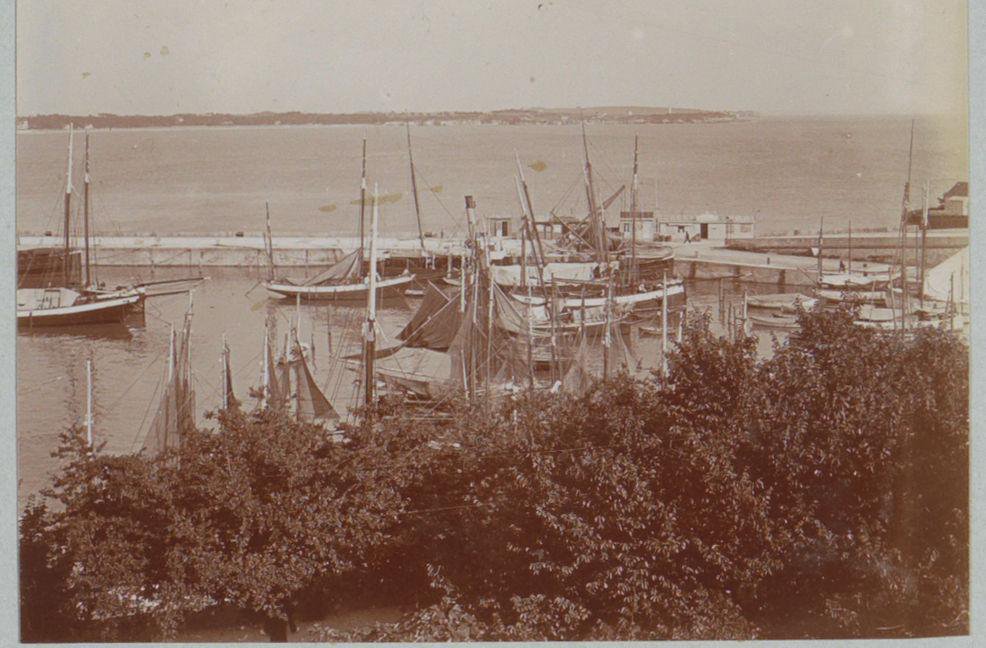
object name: photograph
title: Gezicht op een haven in Frankrijk met zeilboten en pier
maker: Anonymous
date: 1905-1910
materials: paper, photographic support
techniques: gelatin silver print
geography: france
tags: sailing-ship, sailing-boat, harbour (+ view ~ vehicle, ship, etc.), pier, quay, wharf, france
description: Onderdeel van Fotoalbum van een Franse amateurfotograaf met bezienswaardigheden in Frankrijk, Zwitserland en Italië.